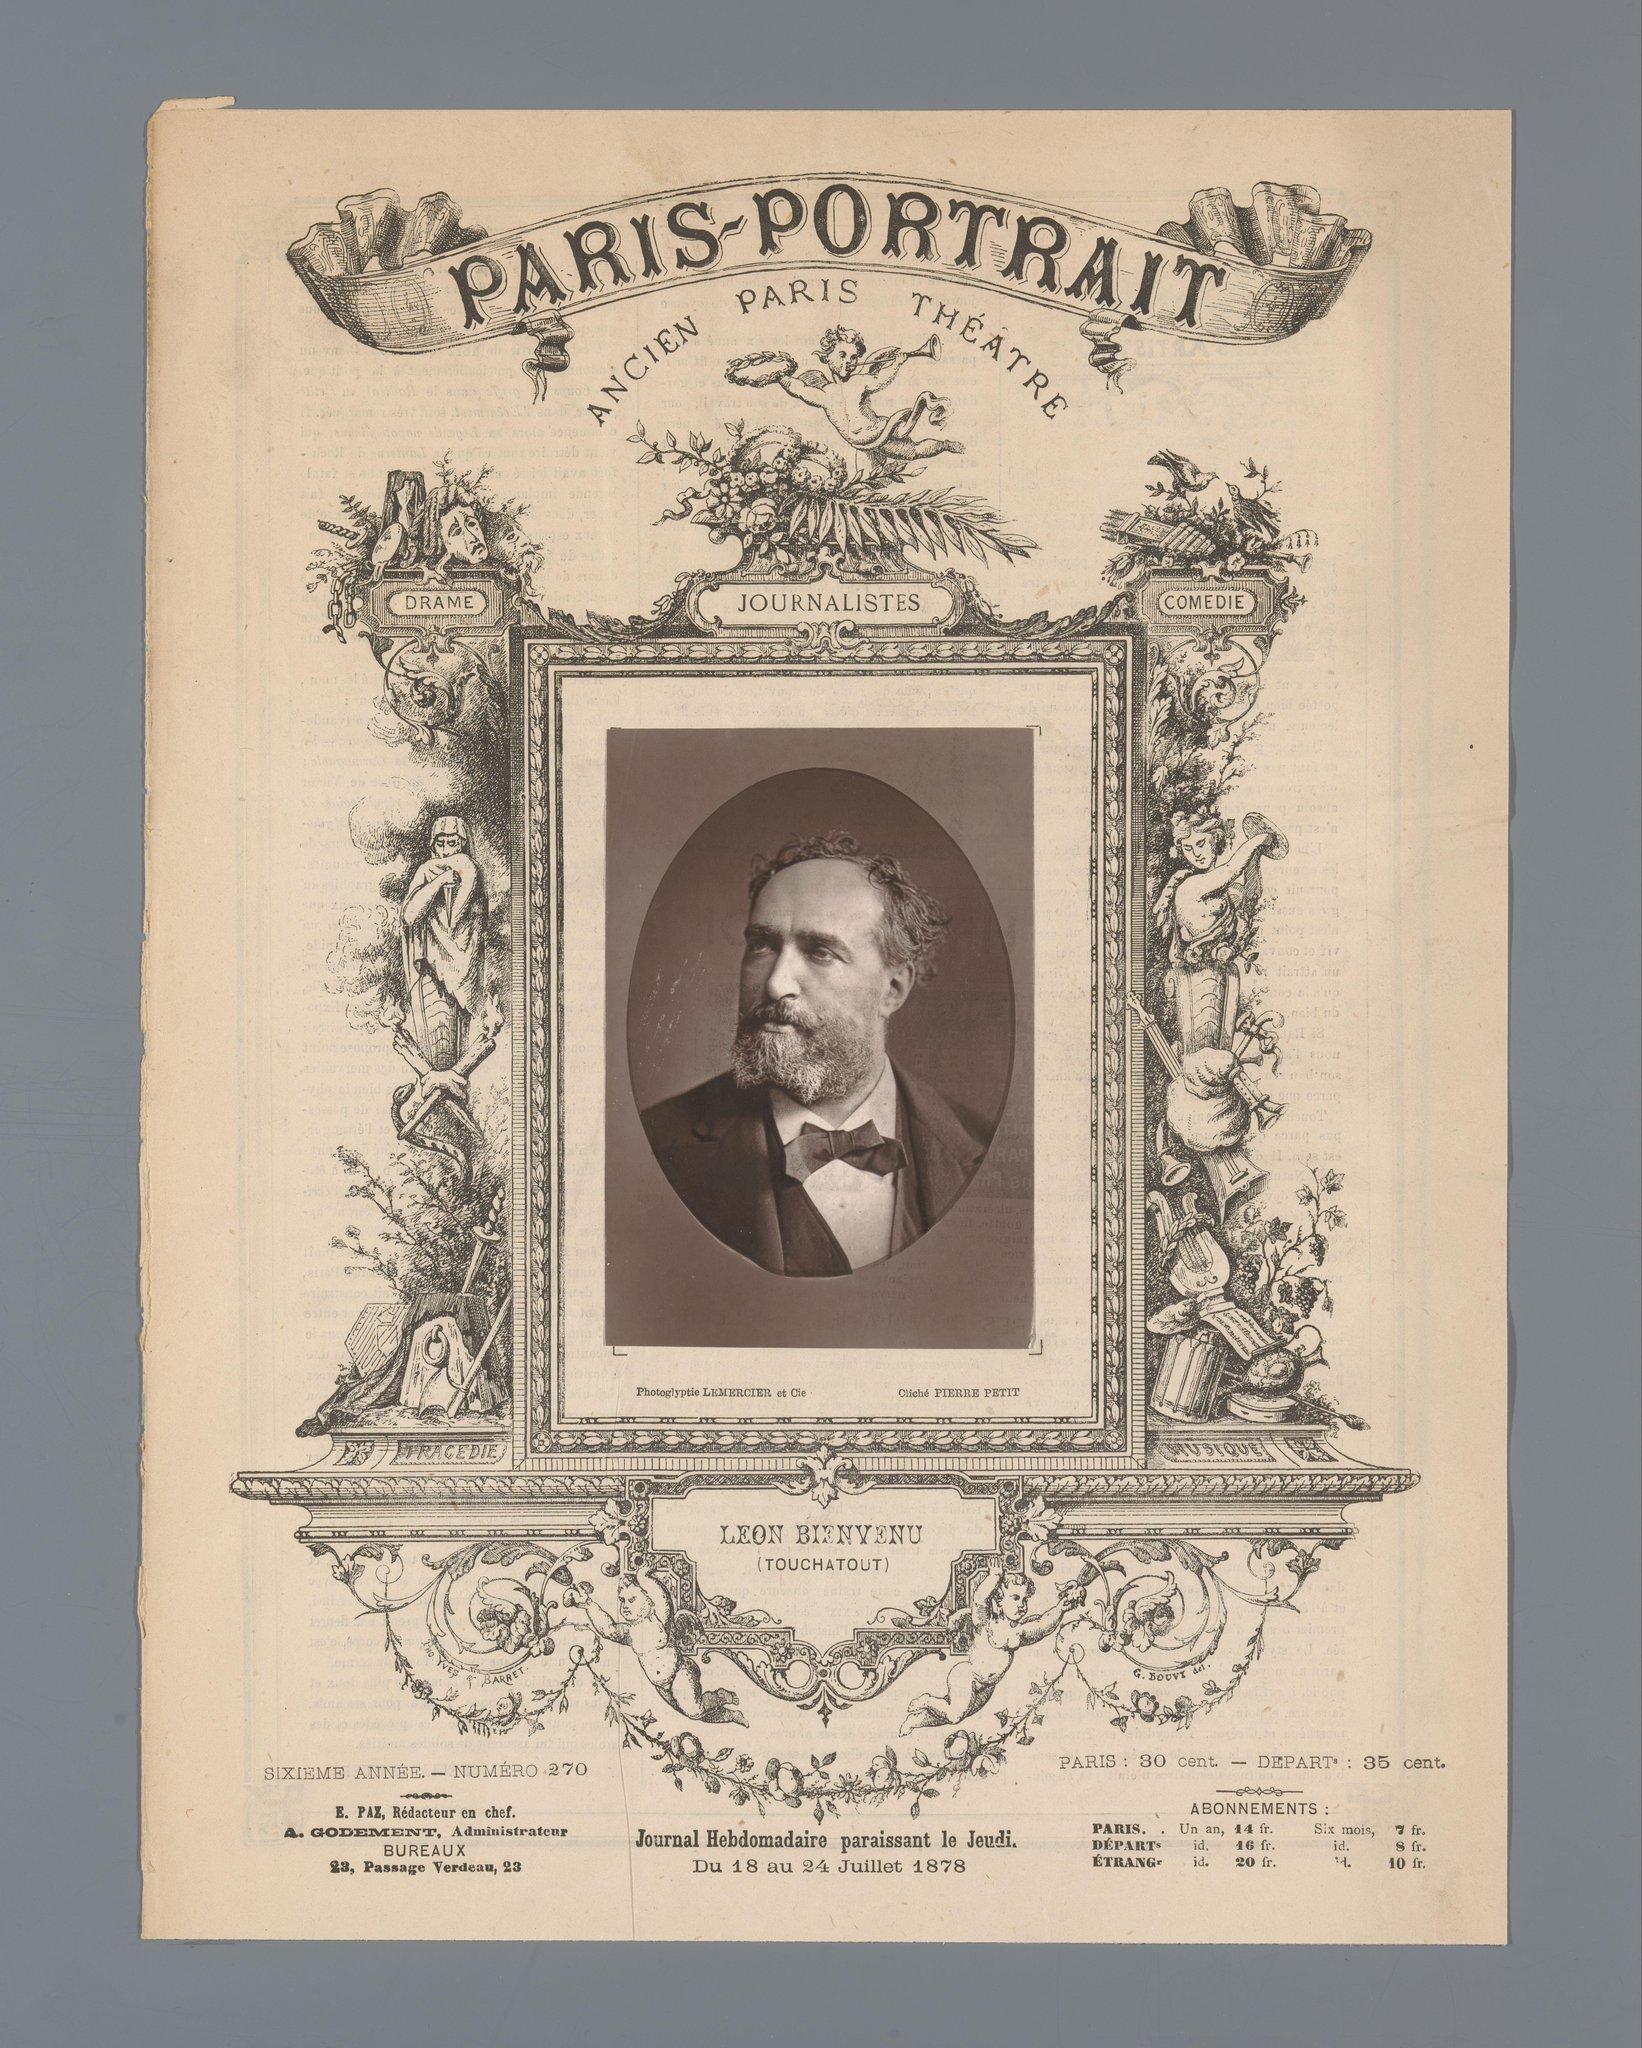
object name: photomechanical print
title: Leon Bienvenu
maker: pierre petit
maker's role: fotograaf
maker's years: 1832-1909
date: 1873-1880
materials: paper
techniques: woodburytype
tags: paris, historical persons